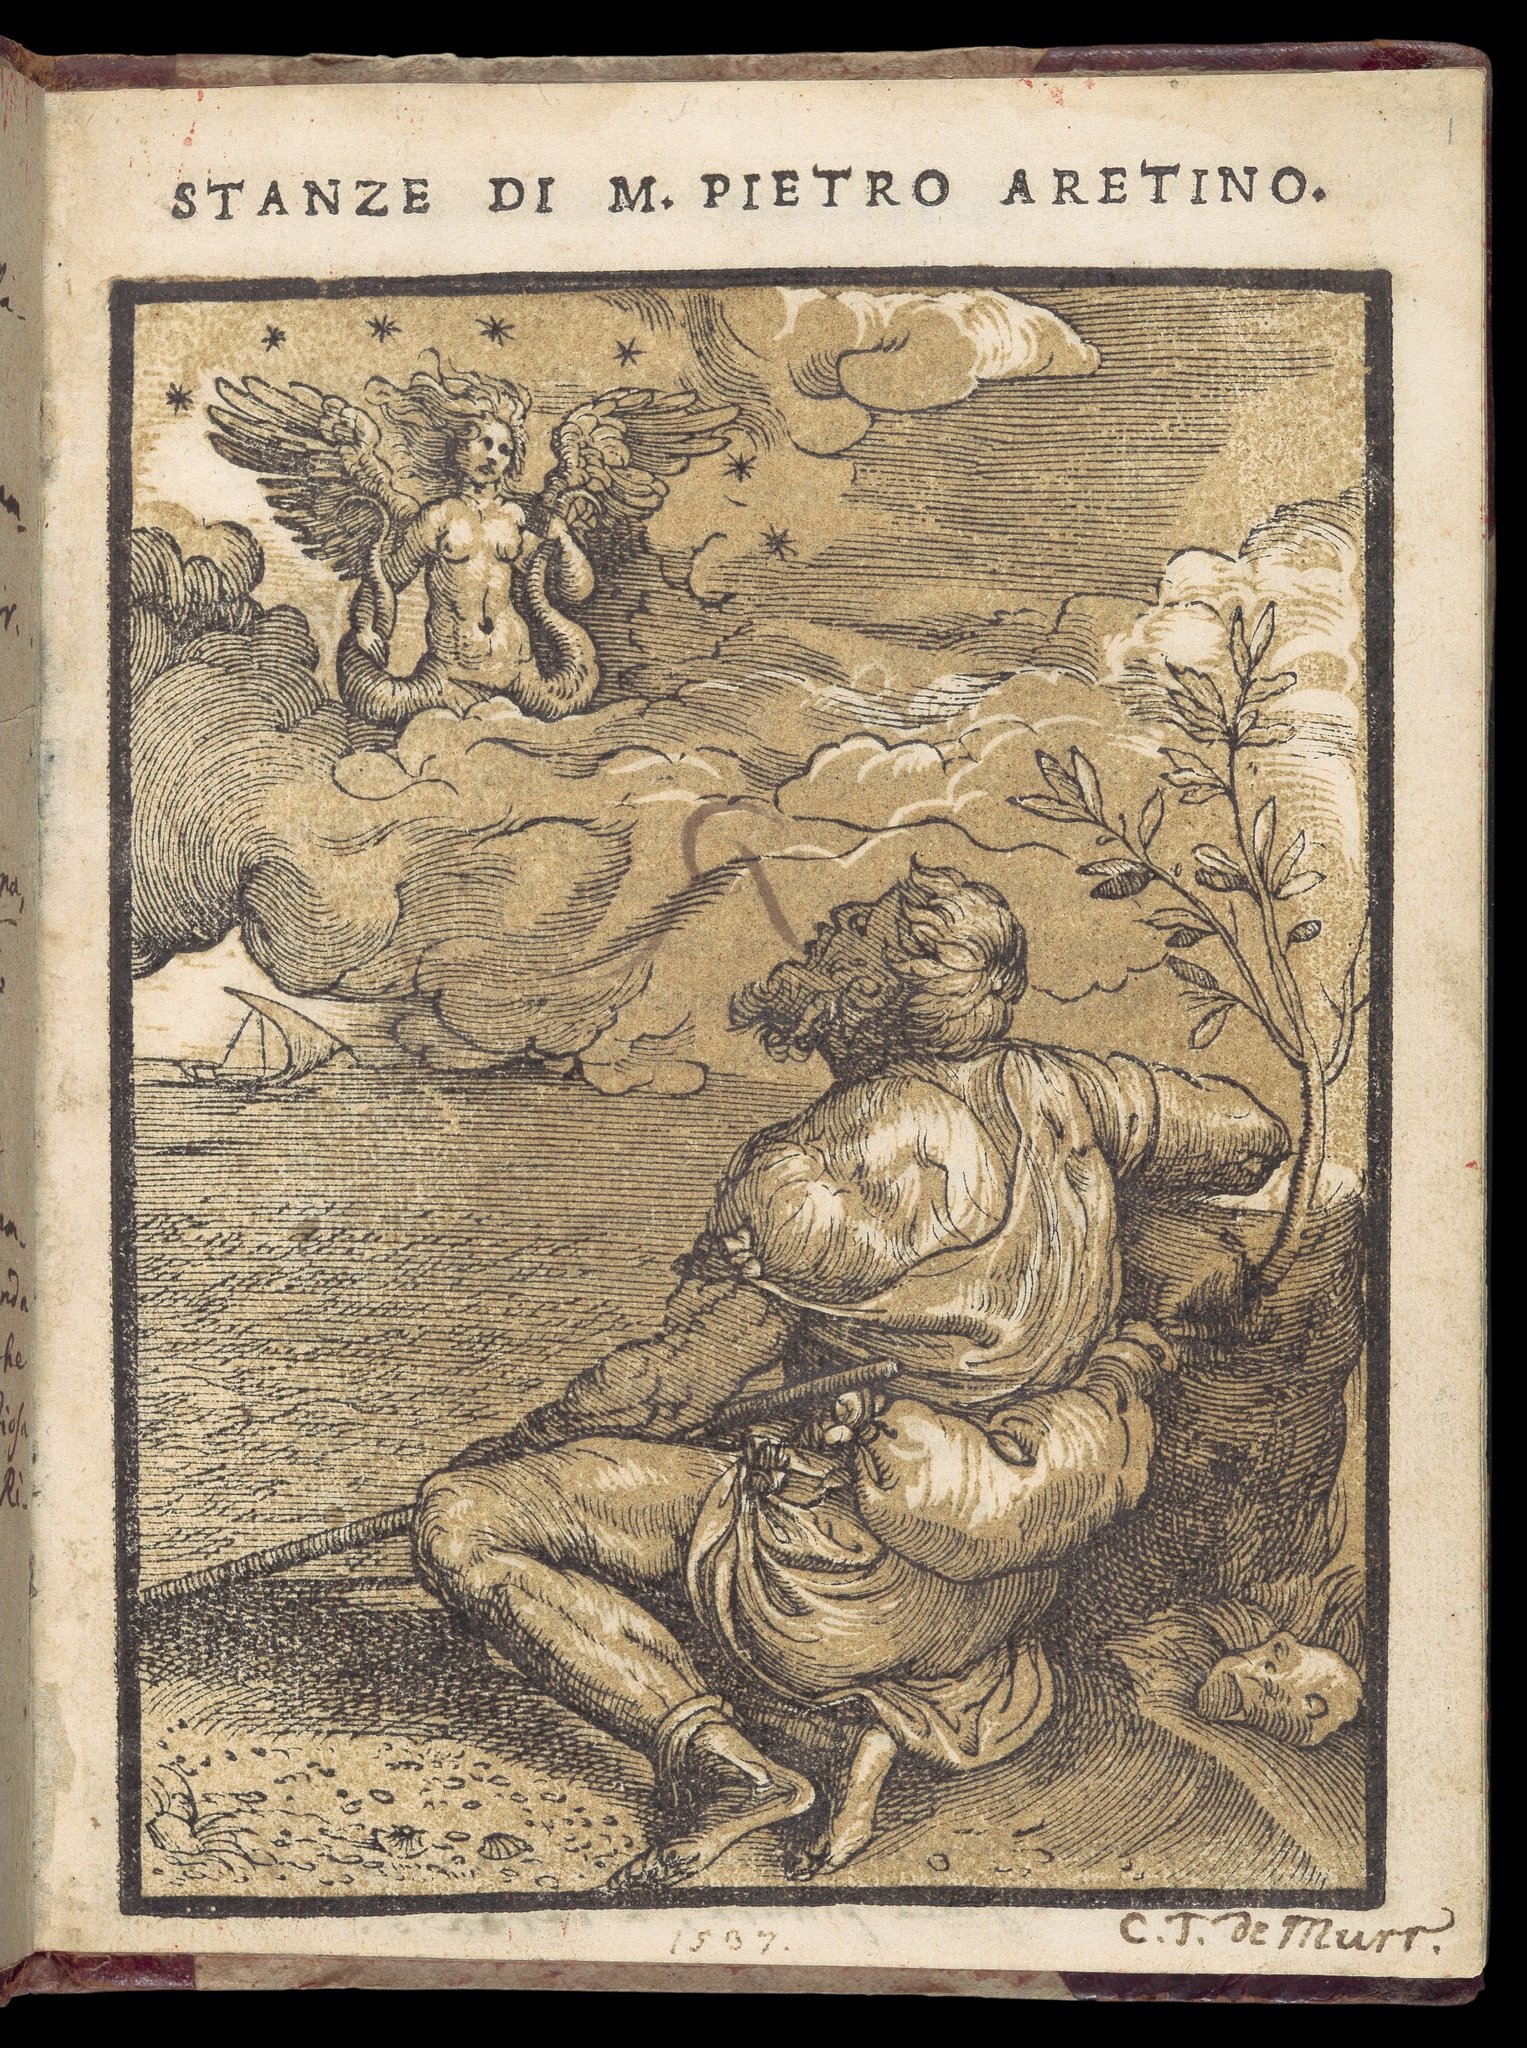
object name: book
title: Stanze di M. Pietro Aretino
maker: pietro aretino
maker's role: author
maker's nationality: italian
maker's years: 1492-1556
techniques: printing, woodcut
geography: italy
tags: men